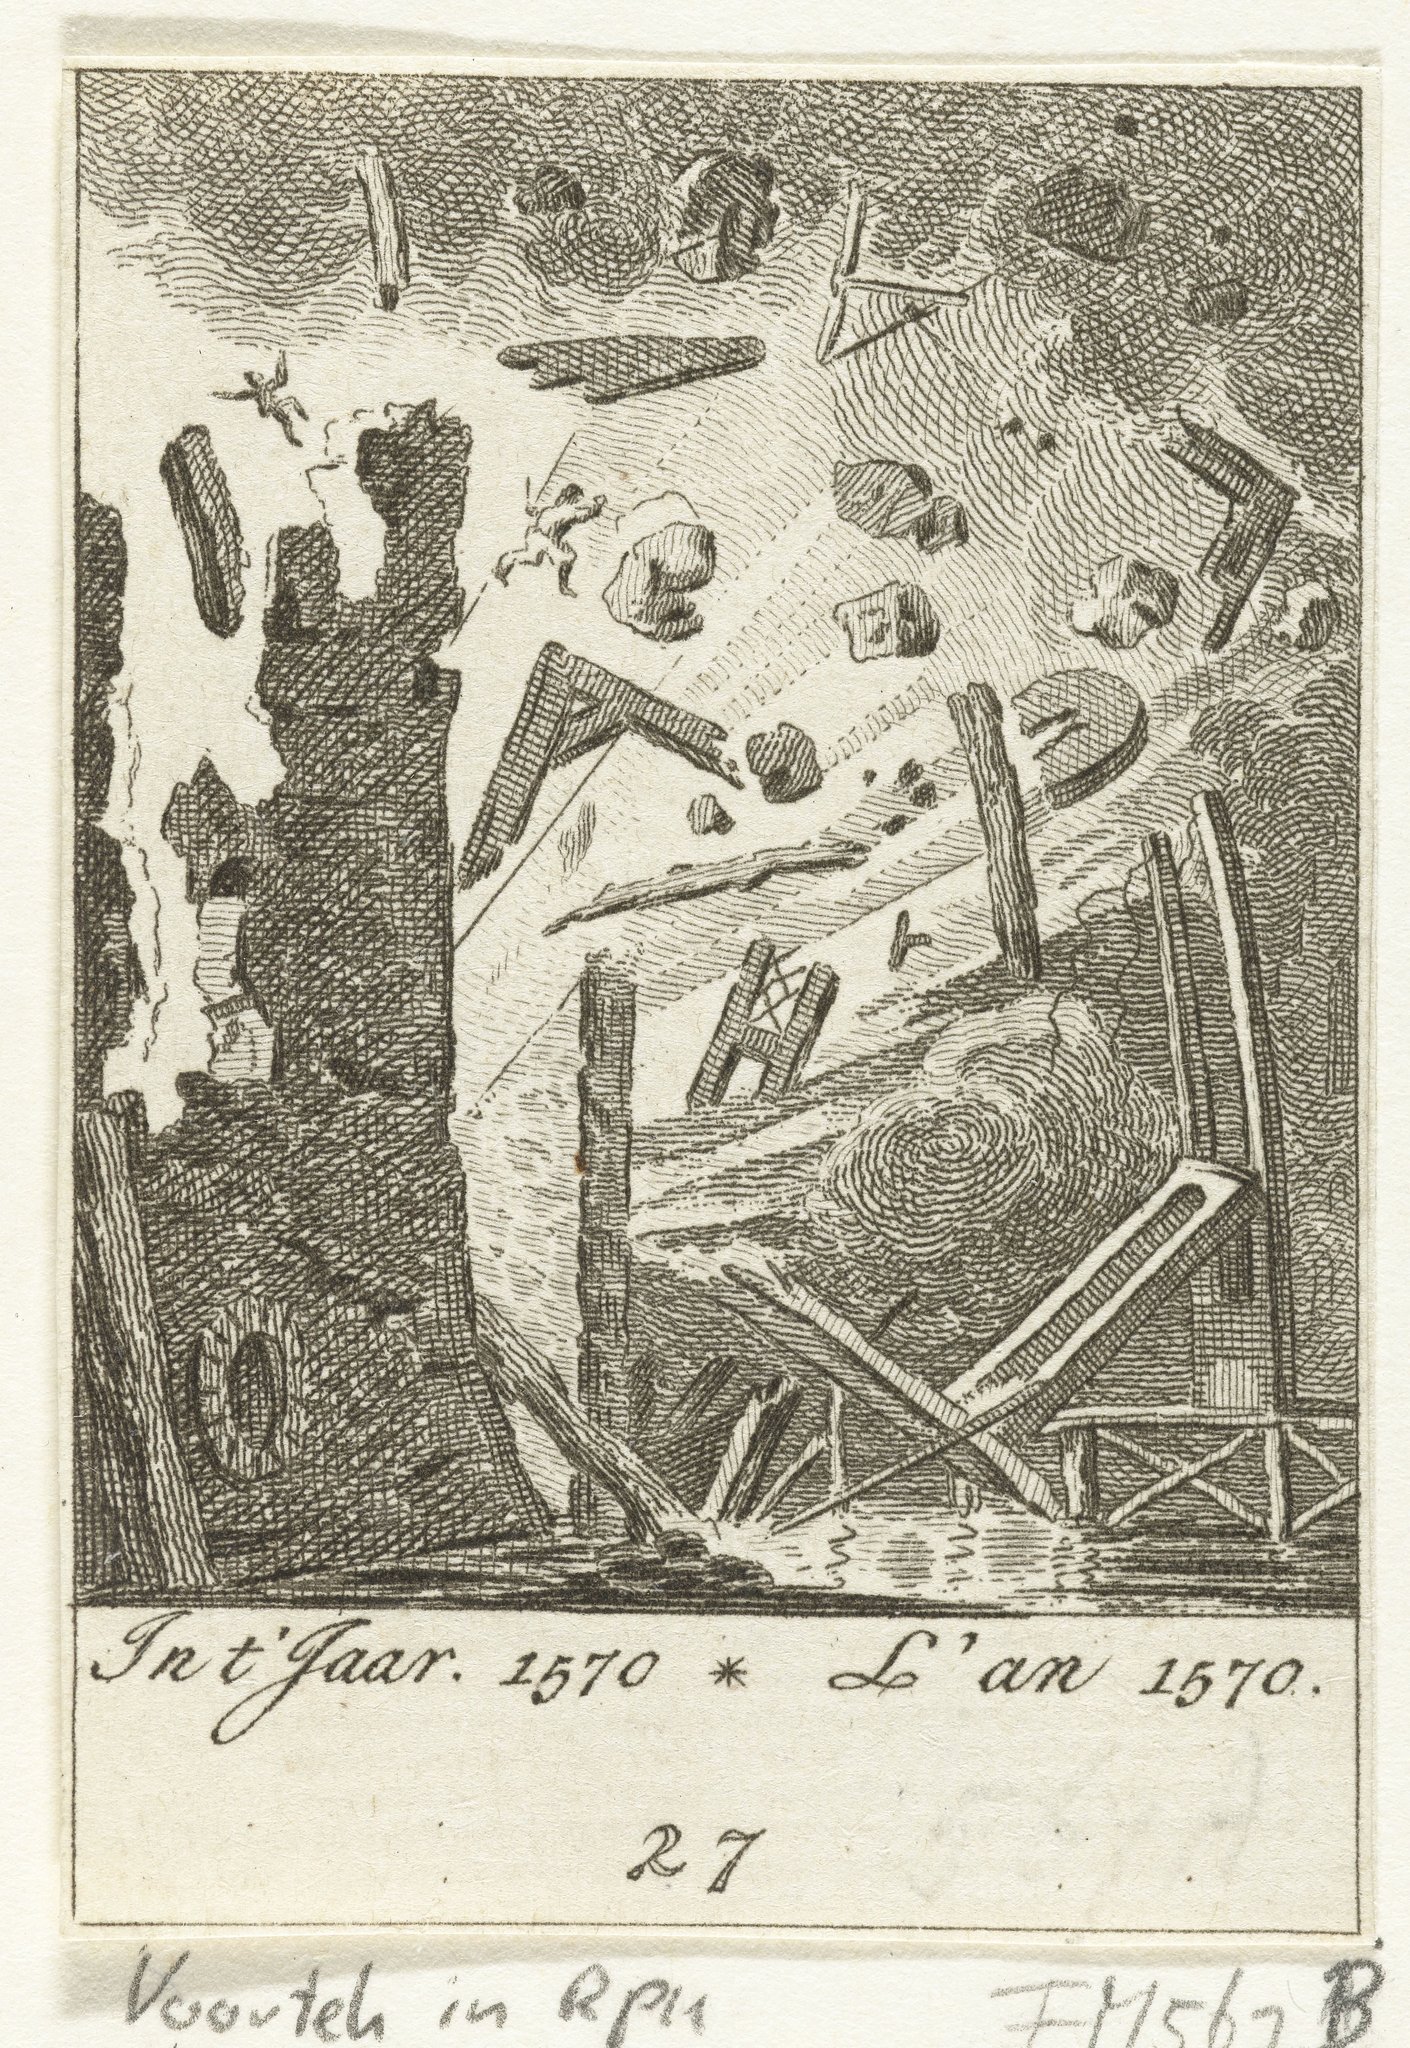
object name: history print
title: In t' Jaar. 1570 / L'an 1570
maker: Anonymous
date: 1775-1799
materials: paper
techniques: etching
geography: netherlands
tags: projectiles, explosives, etc., loevestein castle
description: Ontploffing van Slot Loevestein nadat Herman de Ruiter de brandende lont in het kruitvat heeft gestoken, 19 december 1570.